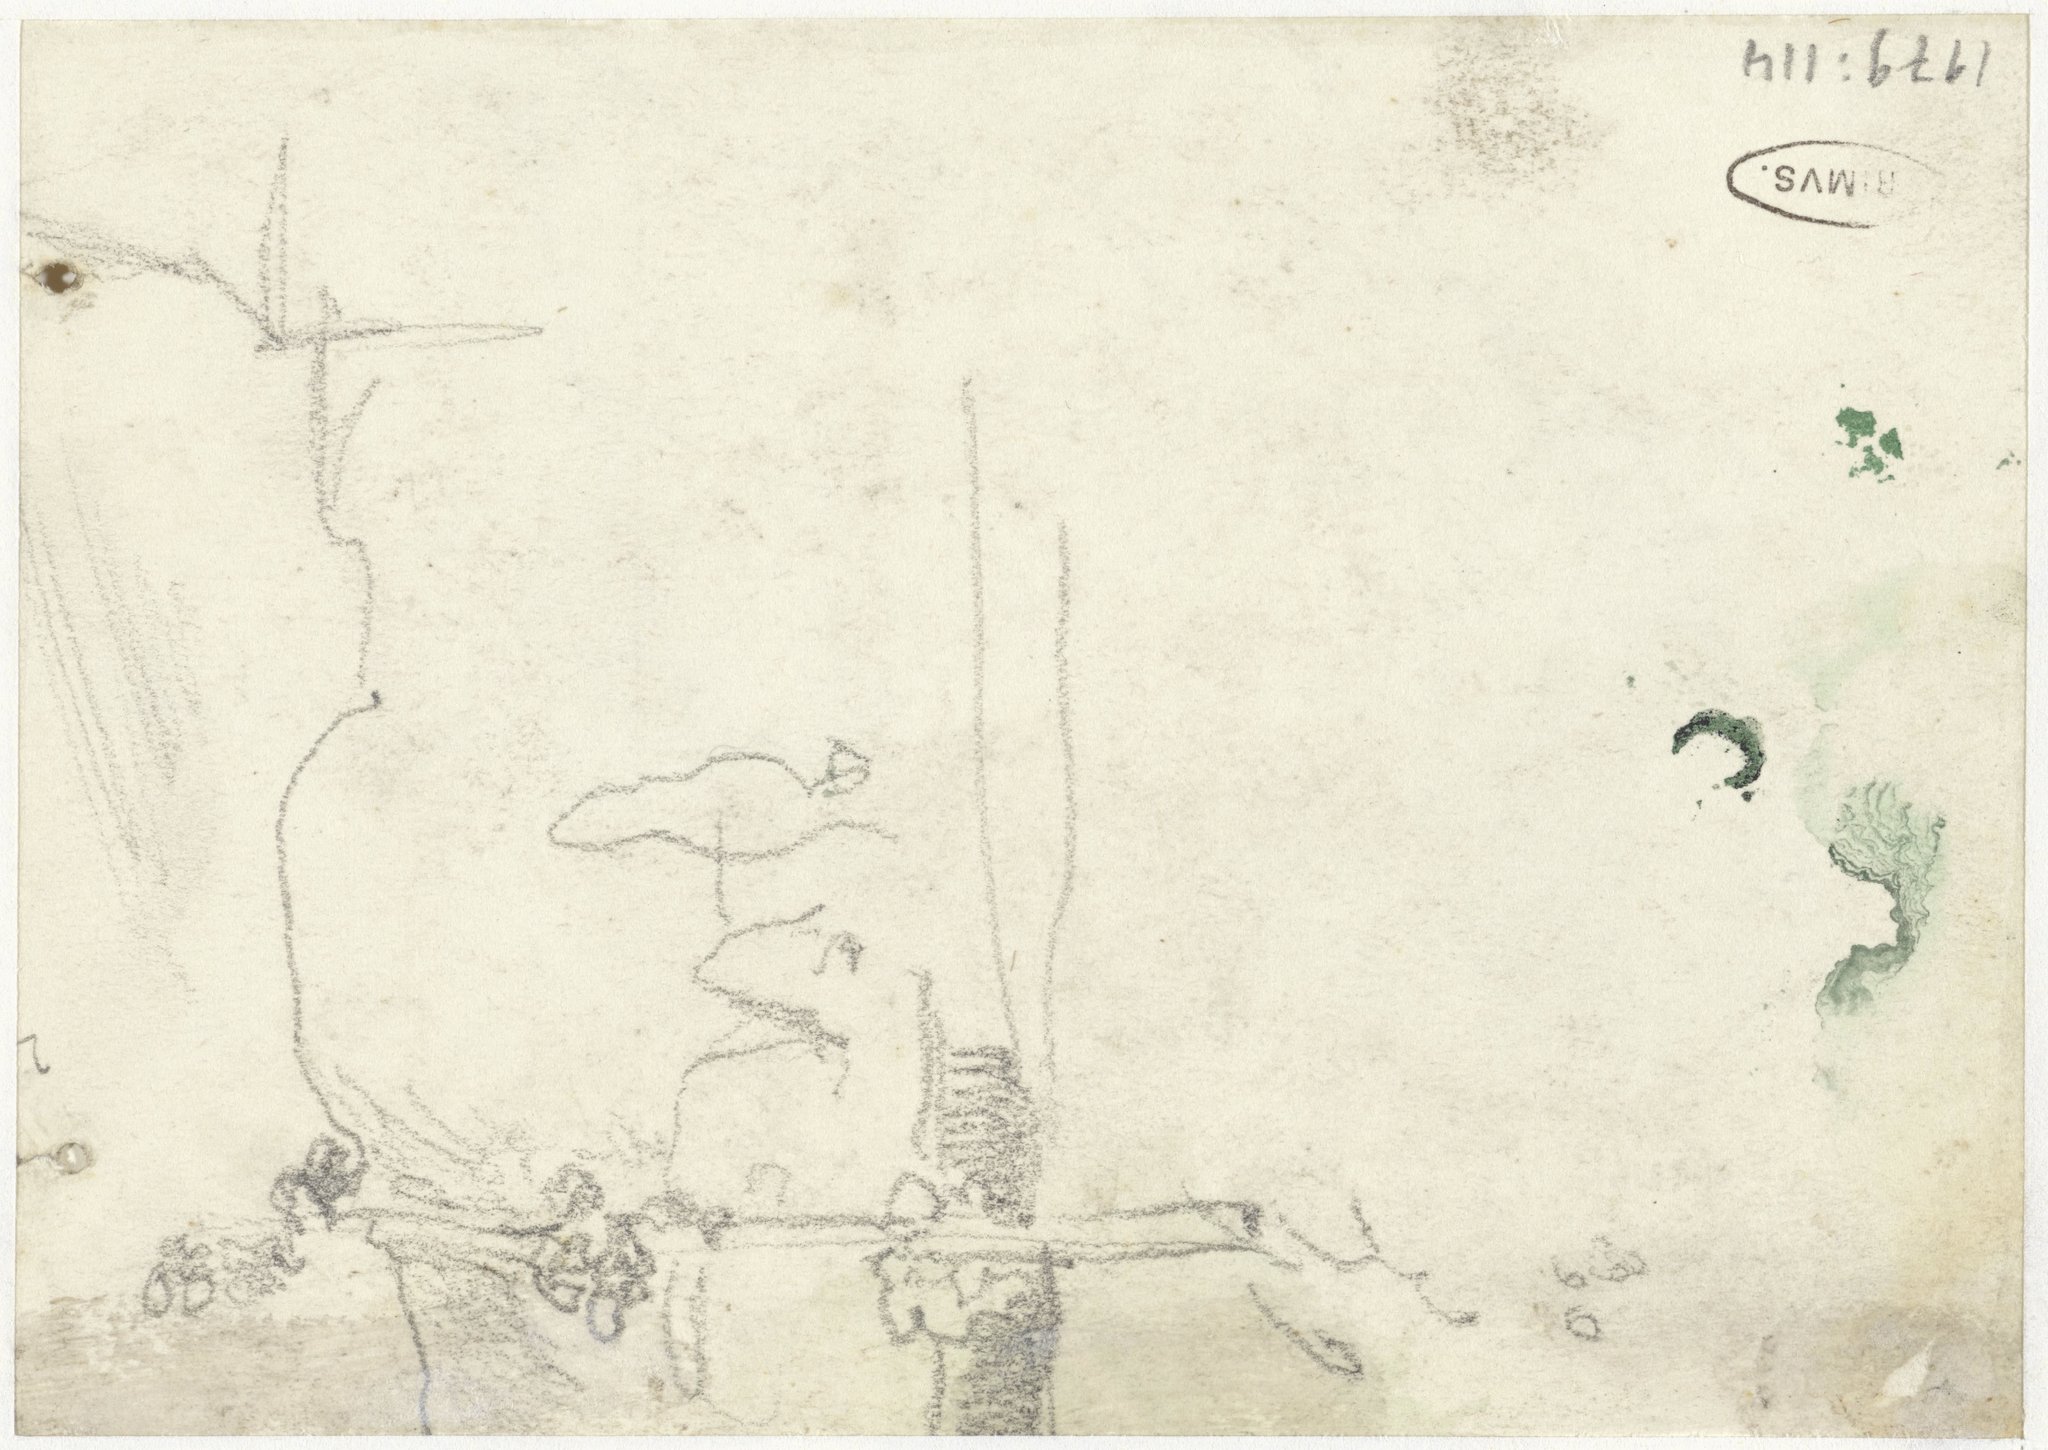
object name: drawing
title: Schets van een landschap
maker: richard nicolaüs roland holst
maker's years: 1868-1938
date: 1903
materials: paper, pencil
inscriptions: date